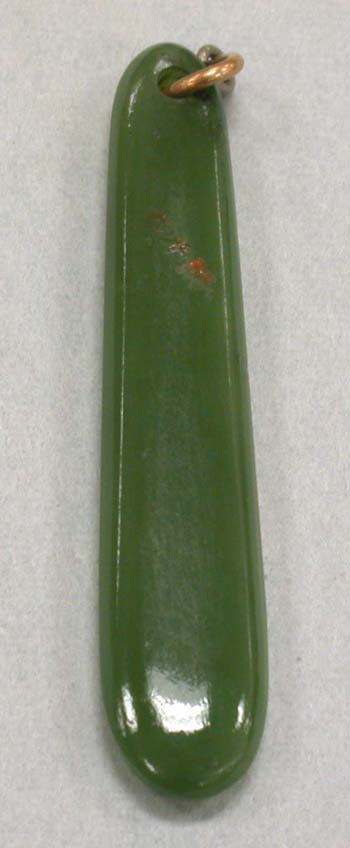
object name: ear drop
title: Ear-drop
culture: new zealander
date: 1801-1900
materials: jade